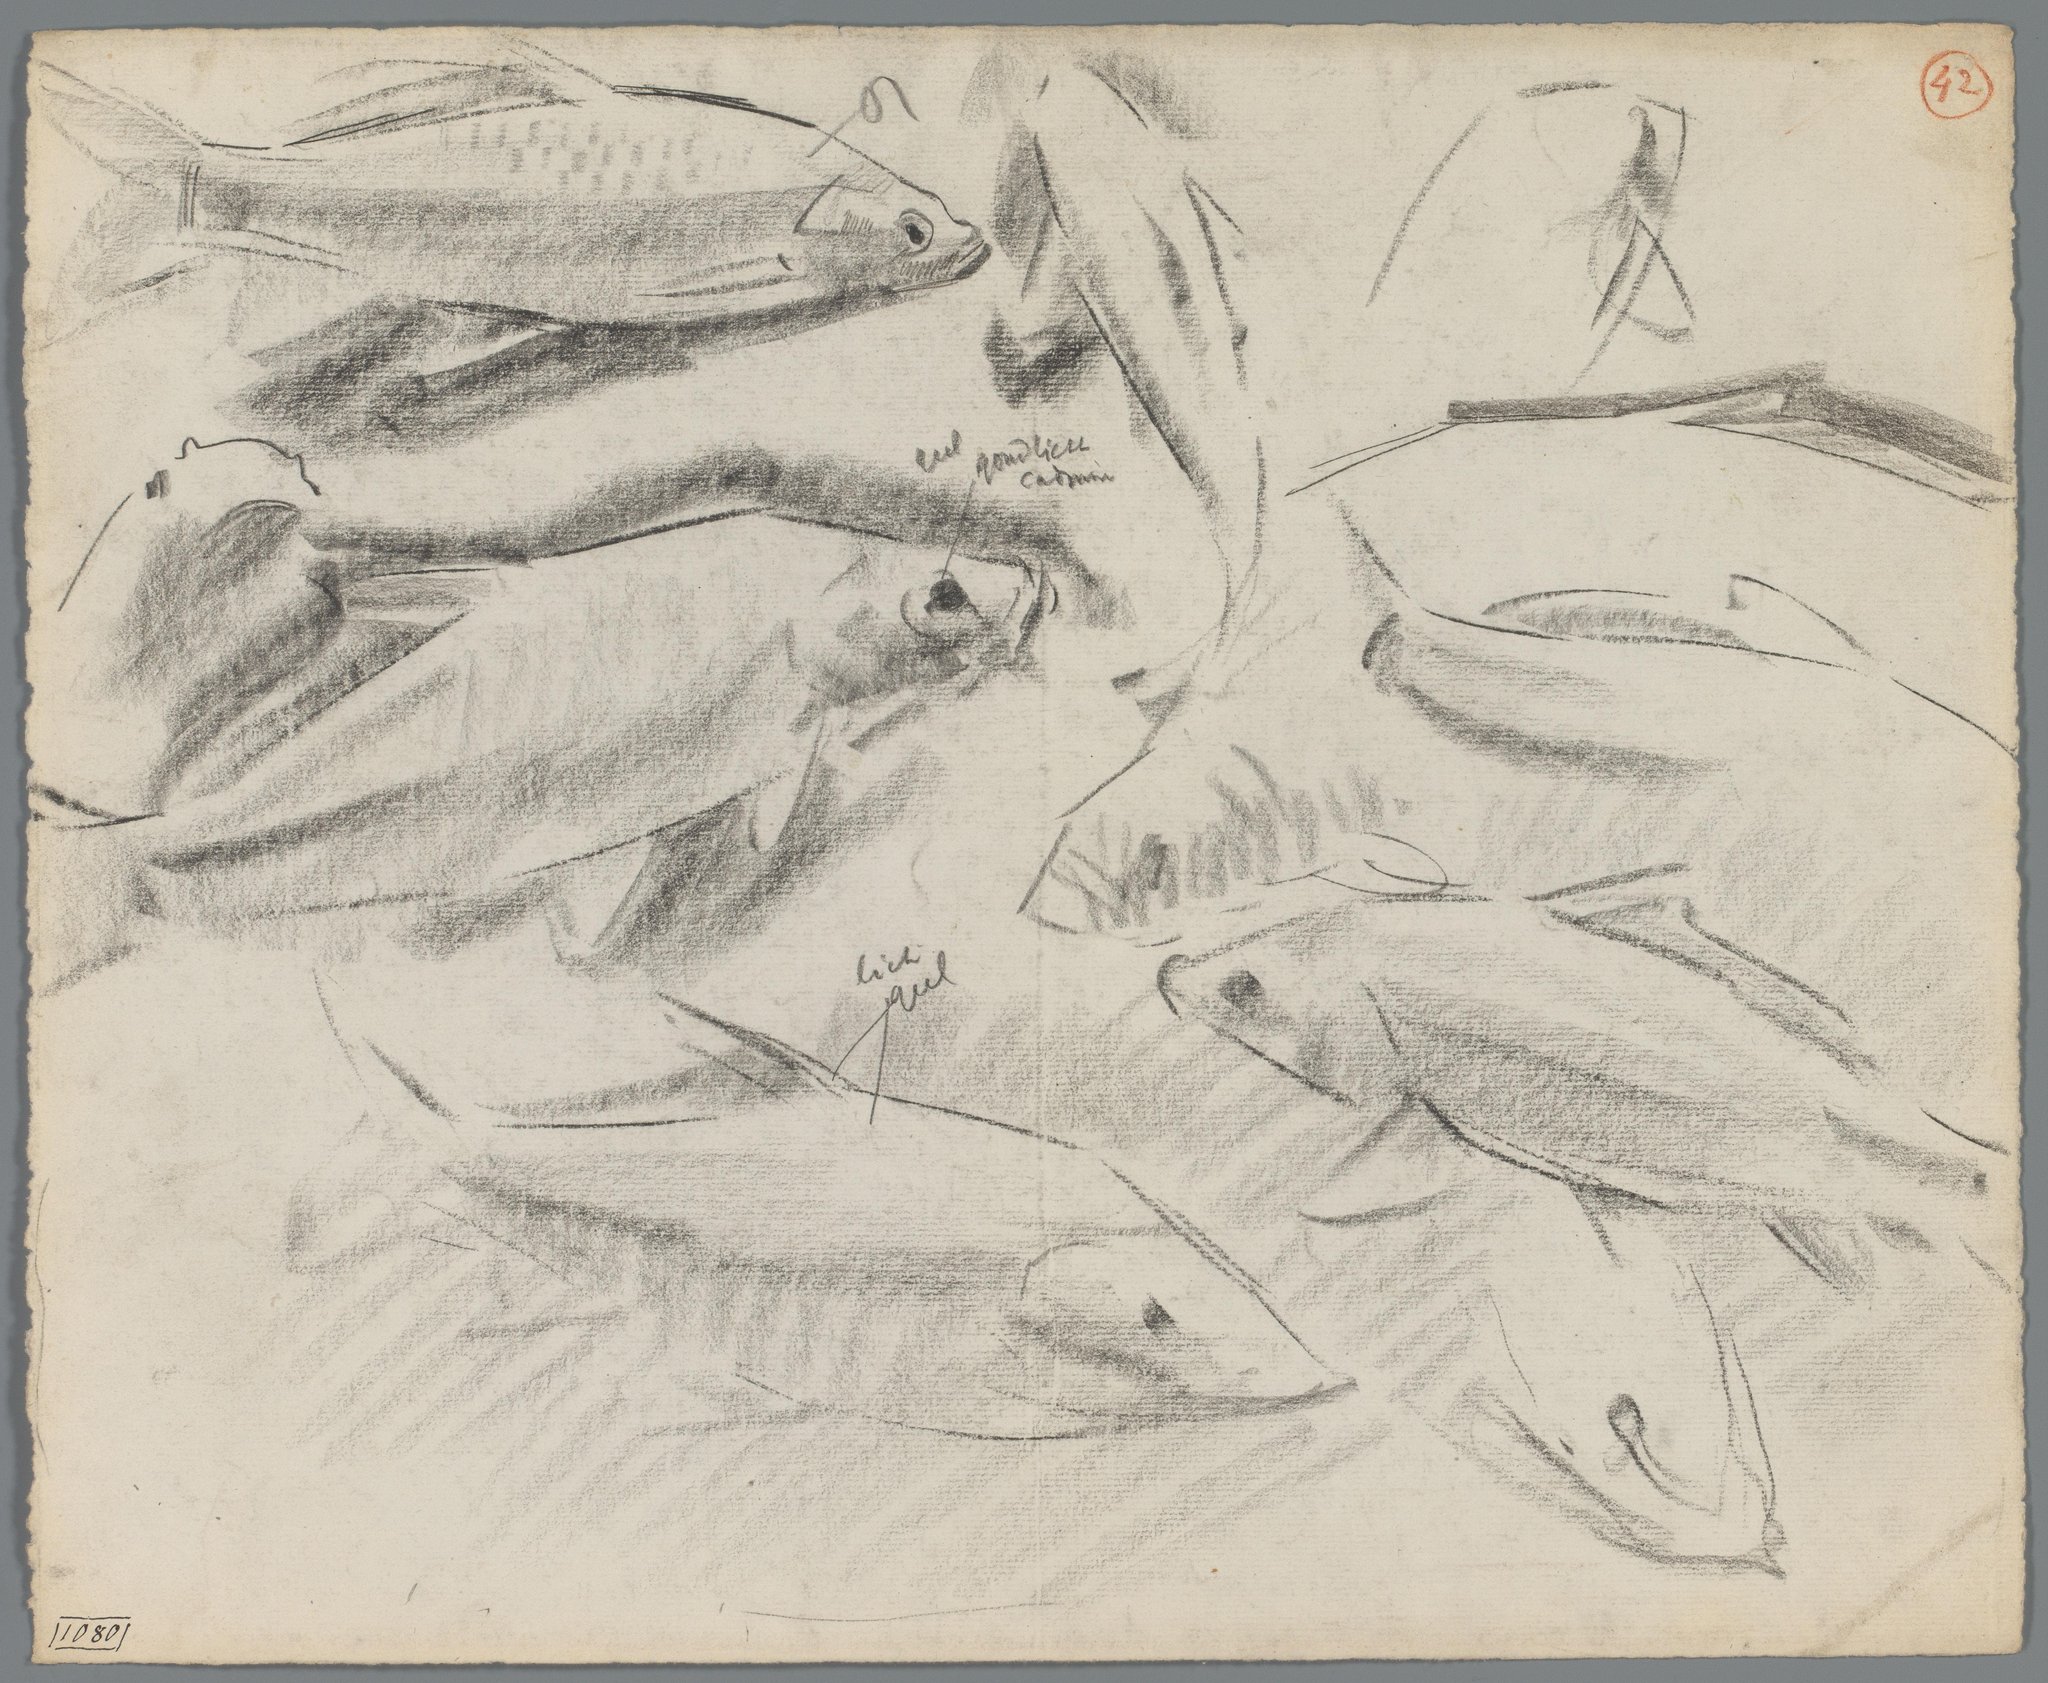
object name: drawing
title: Studies van karpers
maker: gerrit willem dijsselhof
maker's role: designer, draughtsman, print maker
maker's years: 1866-1924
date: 1876-1924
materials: chalk, paper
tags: bony fishes: carp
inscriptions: number: ‘1080’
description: Met aantekeningen. Rechtsboven genummerd: 42.